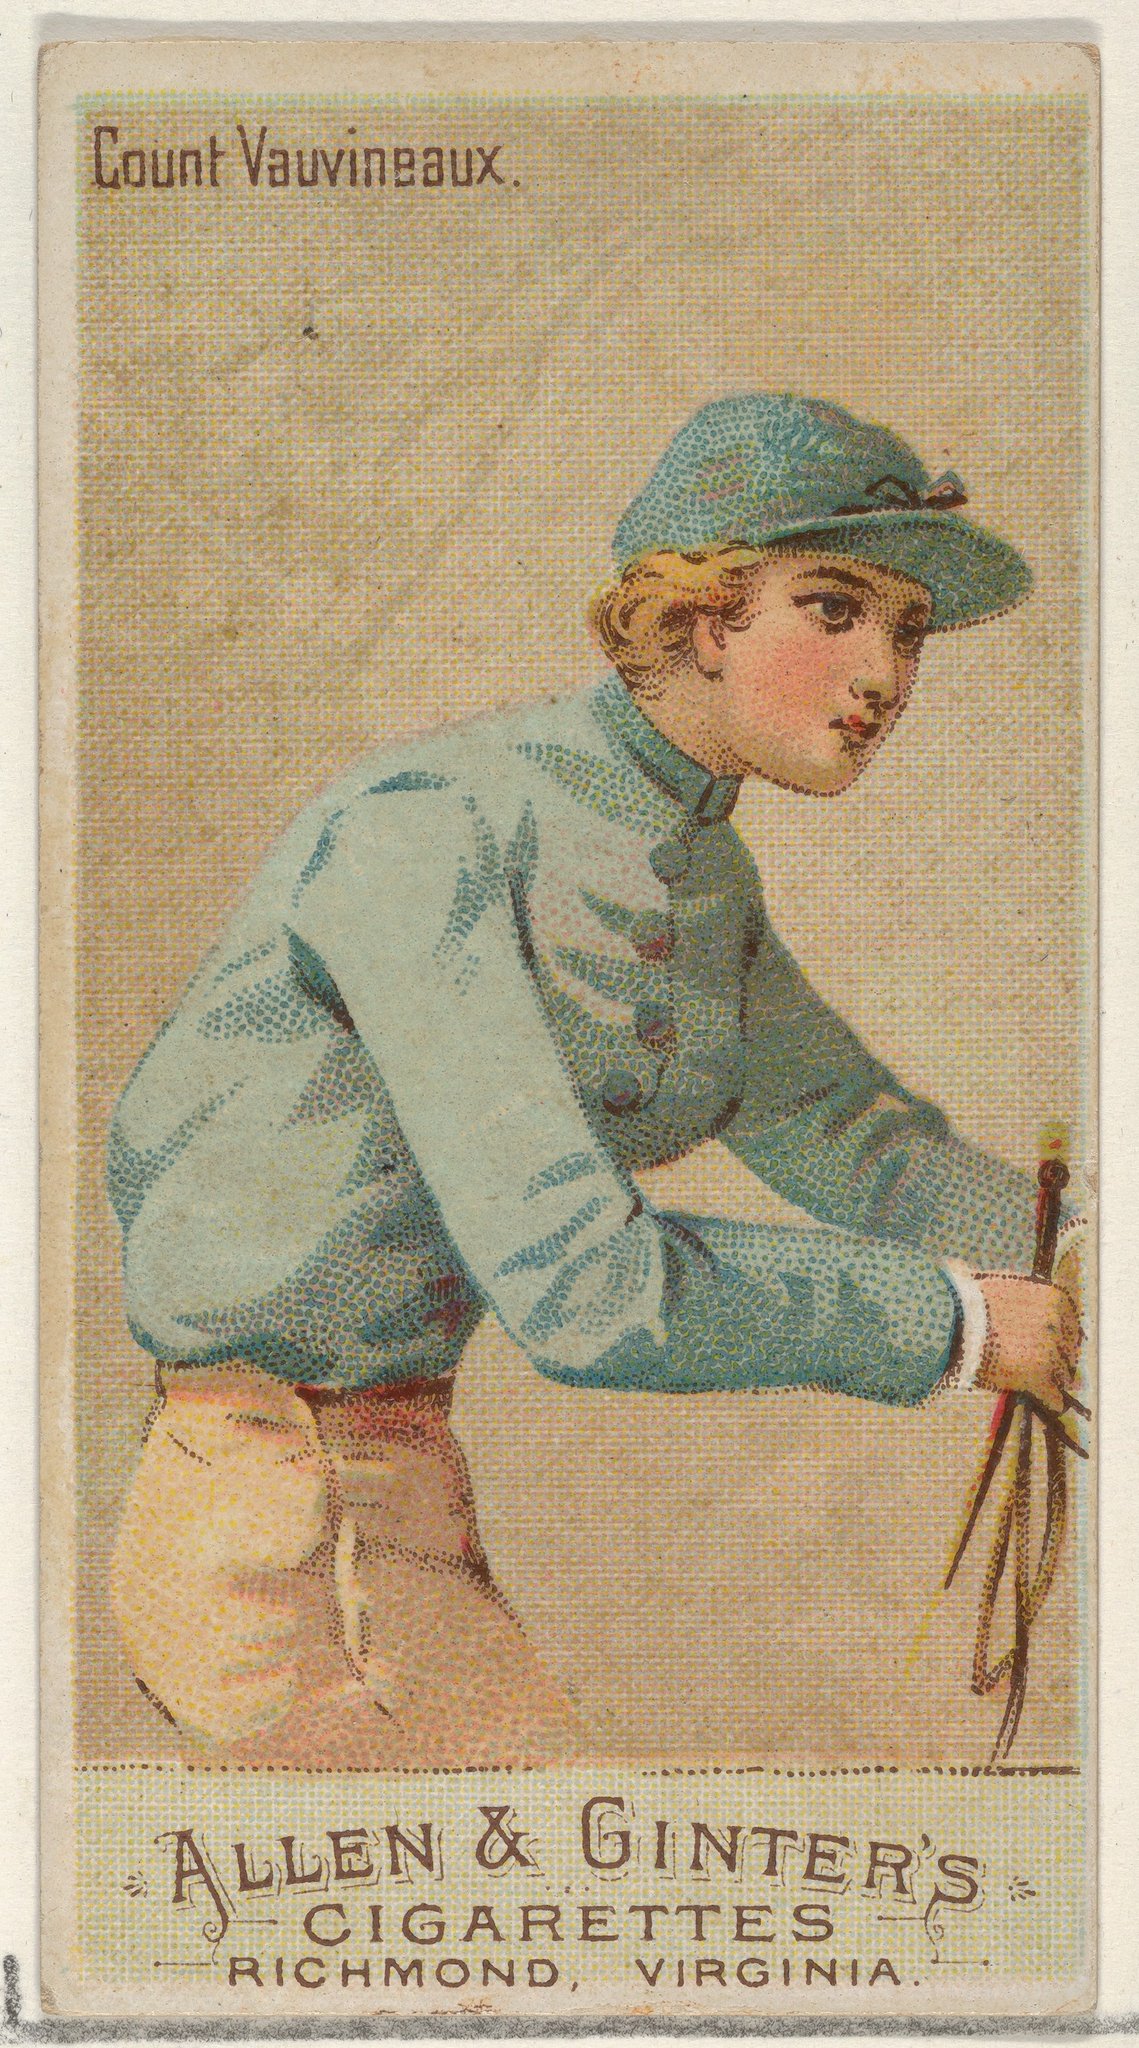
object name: print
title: Count Vauvineaux, from the Racing Colors of the World series (N22a) for Allen & Ginter Cigarettes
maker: allen & ginter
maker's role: publisher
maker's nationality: american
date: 1888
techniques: color lithograph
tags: women,jockeys